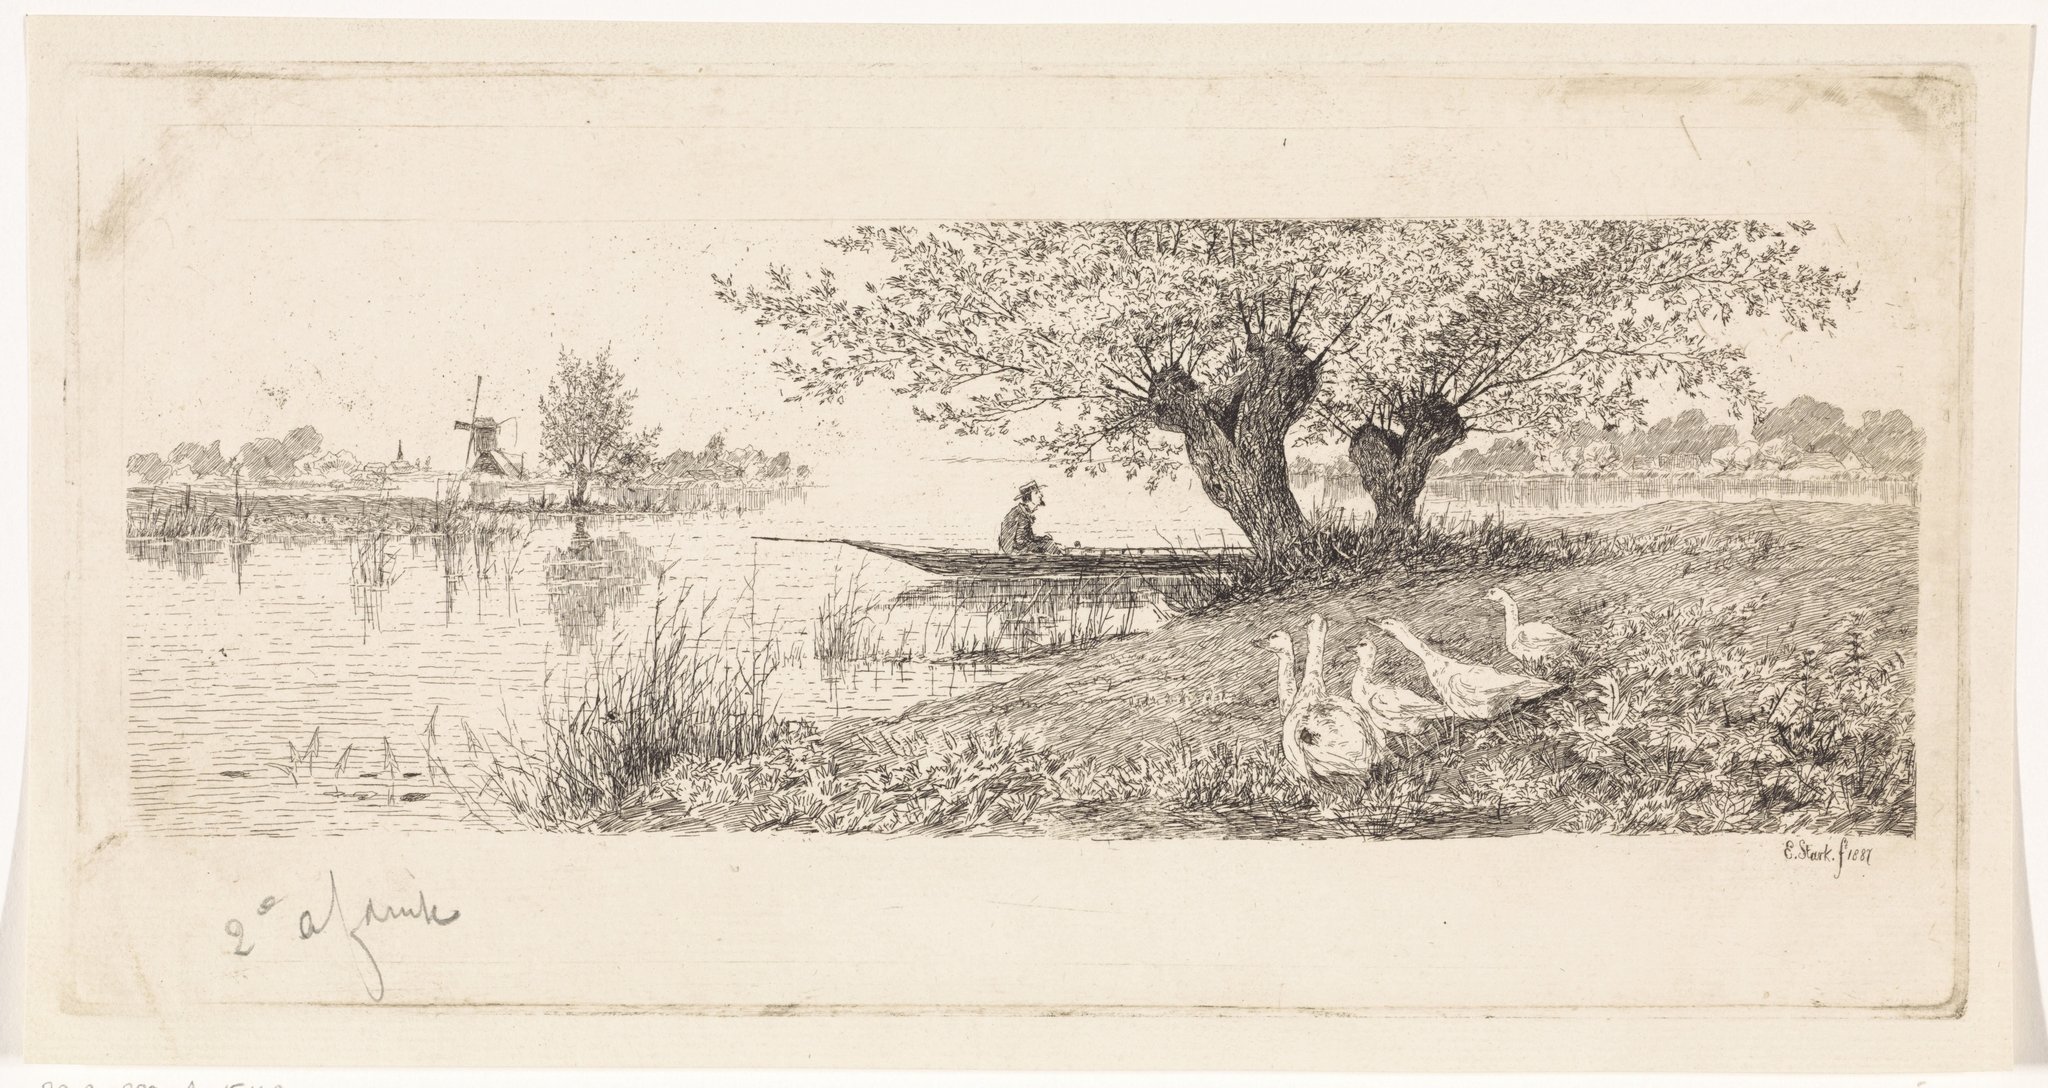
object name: print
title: Rivierlandschap met een man in een boot en ganzen op de oever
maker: elias stark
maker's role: draughtsman, print maker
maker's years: 1849-1933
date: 1887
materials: paper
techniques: etching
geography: nieuwer-amstel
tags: water-birds: goose, river, rowing-boat, canoe, etc., trees: willow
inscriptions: collector's mark: Lugt 2228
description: Op een rivier een man in een boot bij twee knotwilgen. Rechts op de oever ganzen. Links aan de horizon een molen.